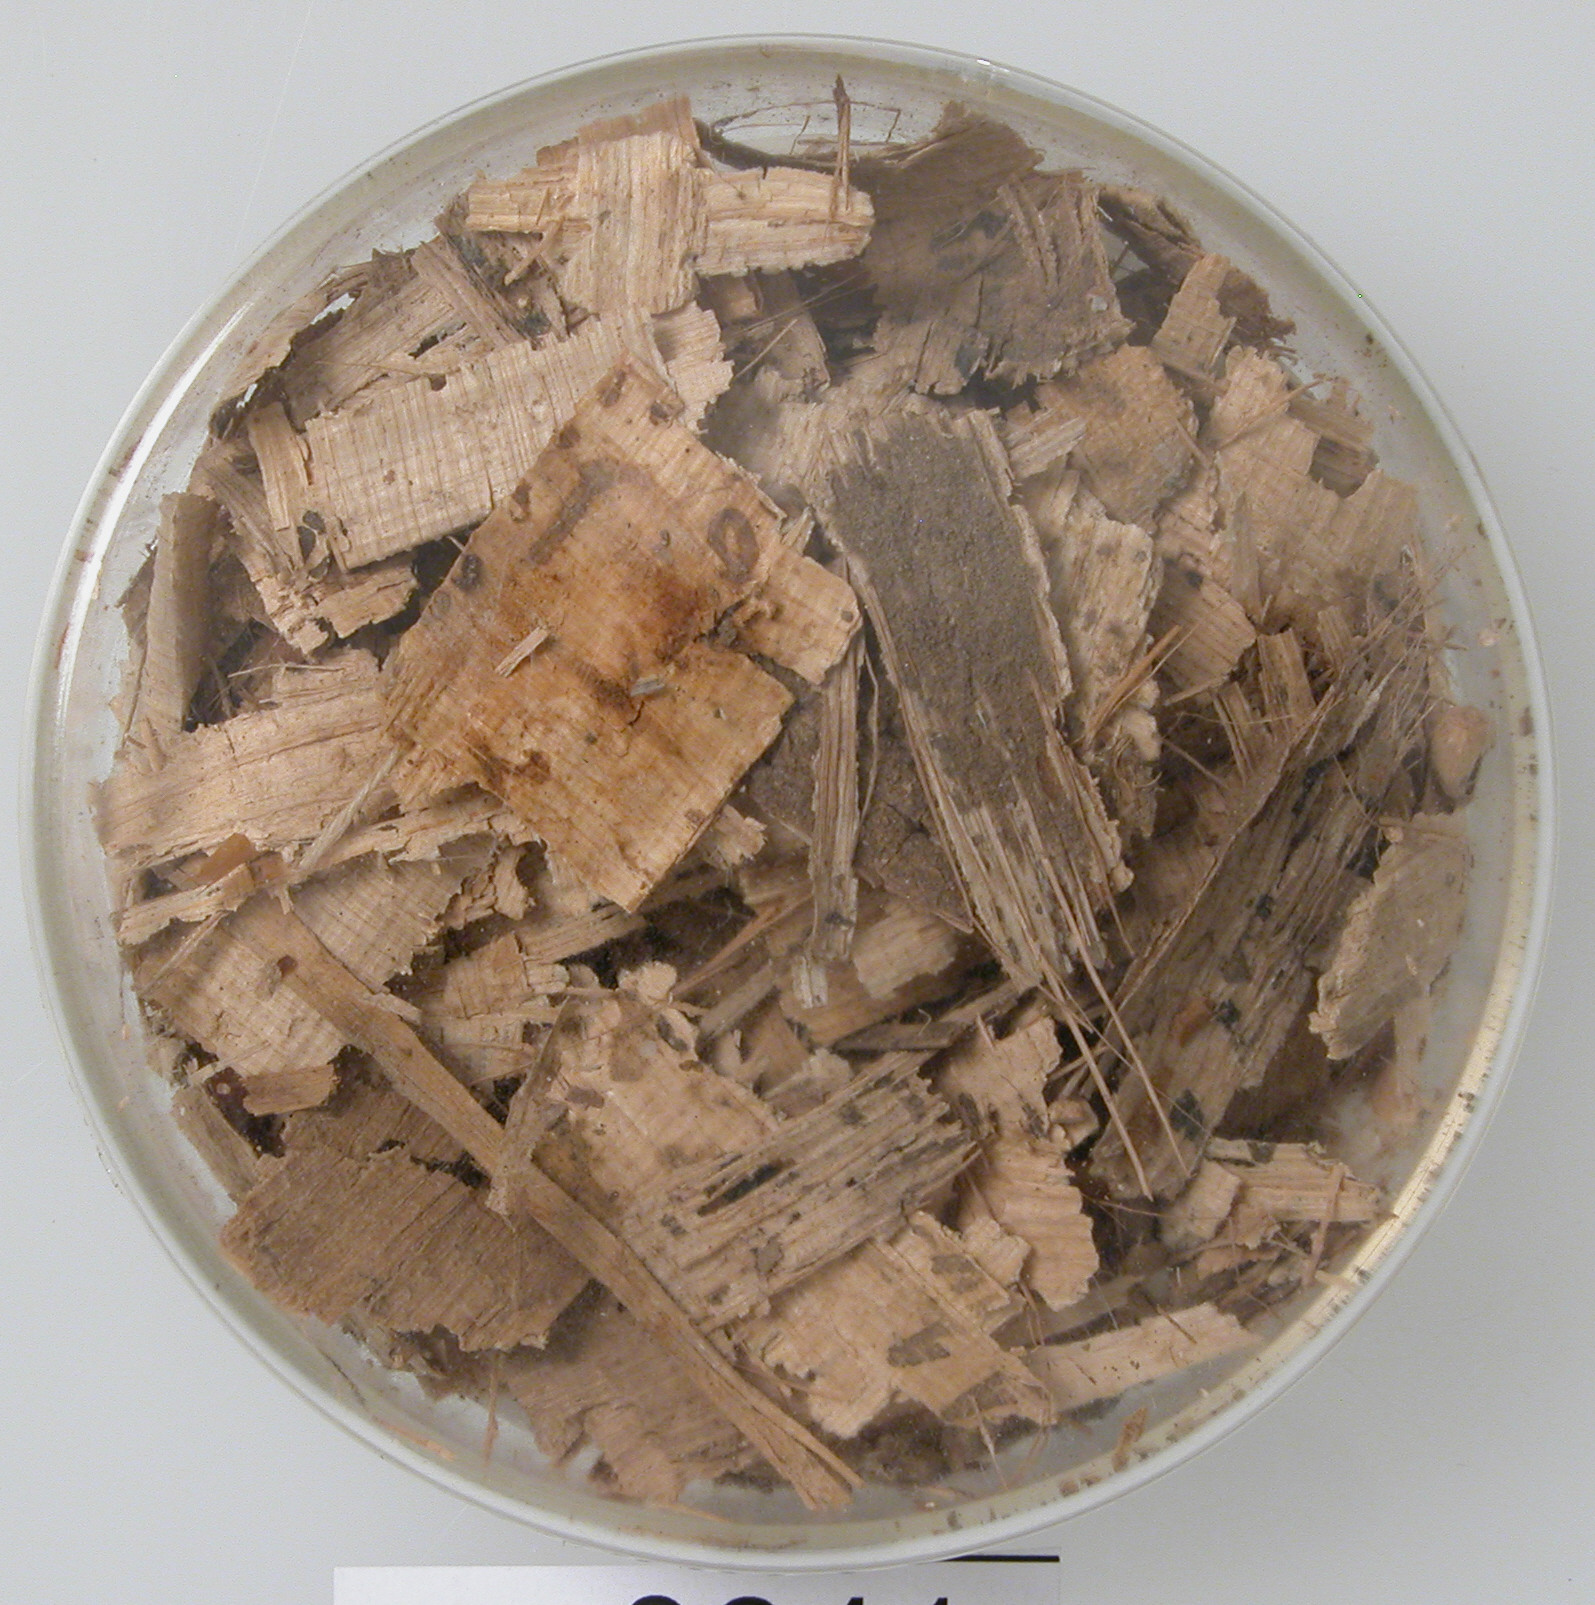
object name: fragment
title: Papyri Fragments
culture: coptic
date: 601-700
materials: ink, papyrus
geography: egypt